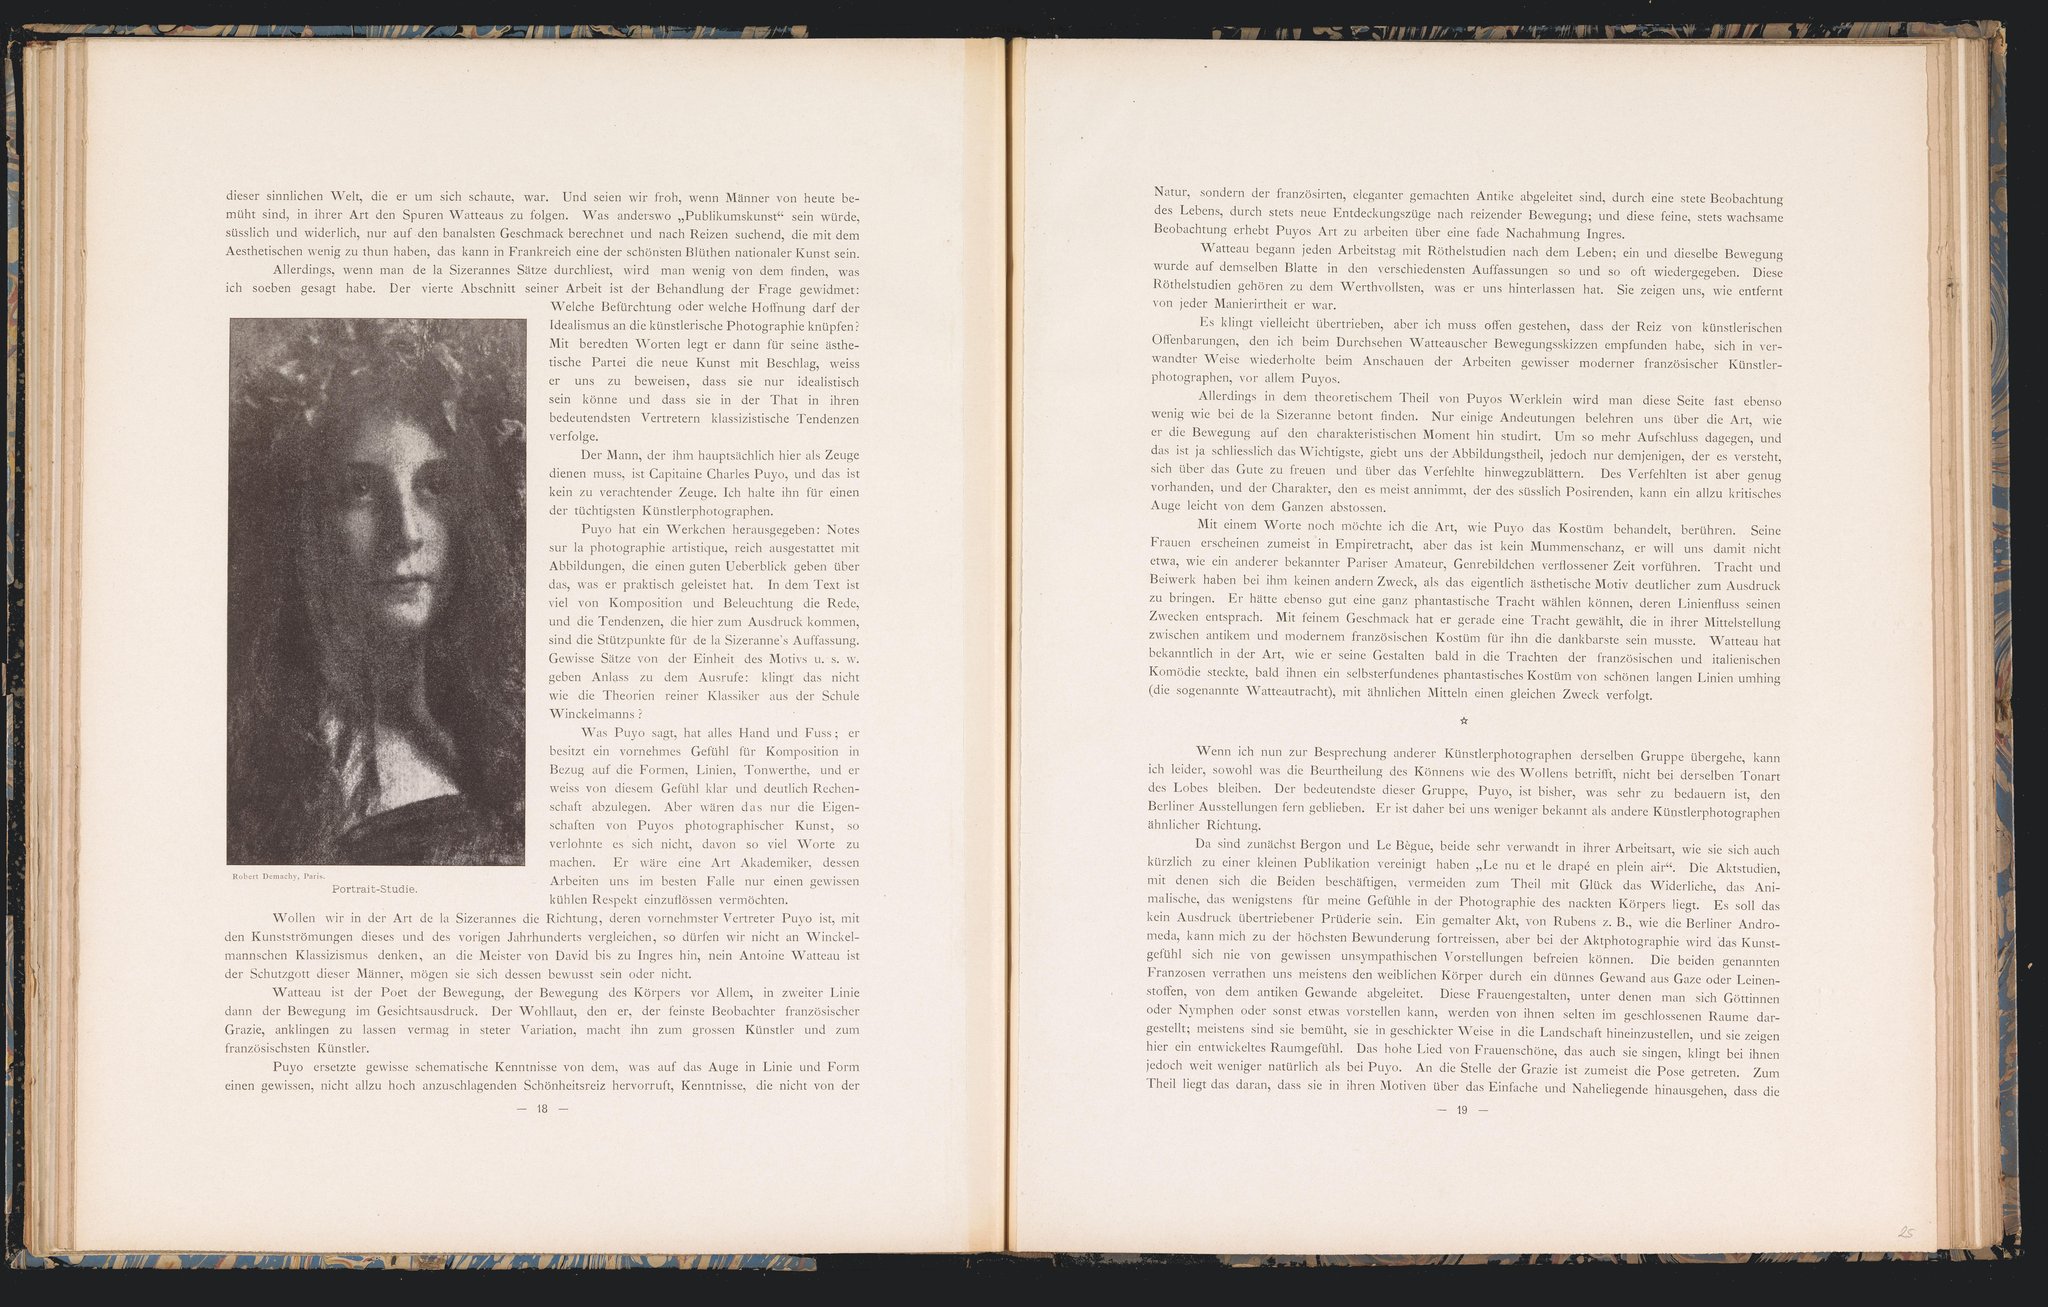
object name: photomechanical print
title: Portret van een onbekende vrouw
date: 1889-1899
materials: paper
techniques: autotype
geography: france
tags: anonymous historical person portrayed - bb - woman